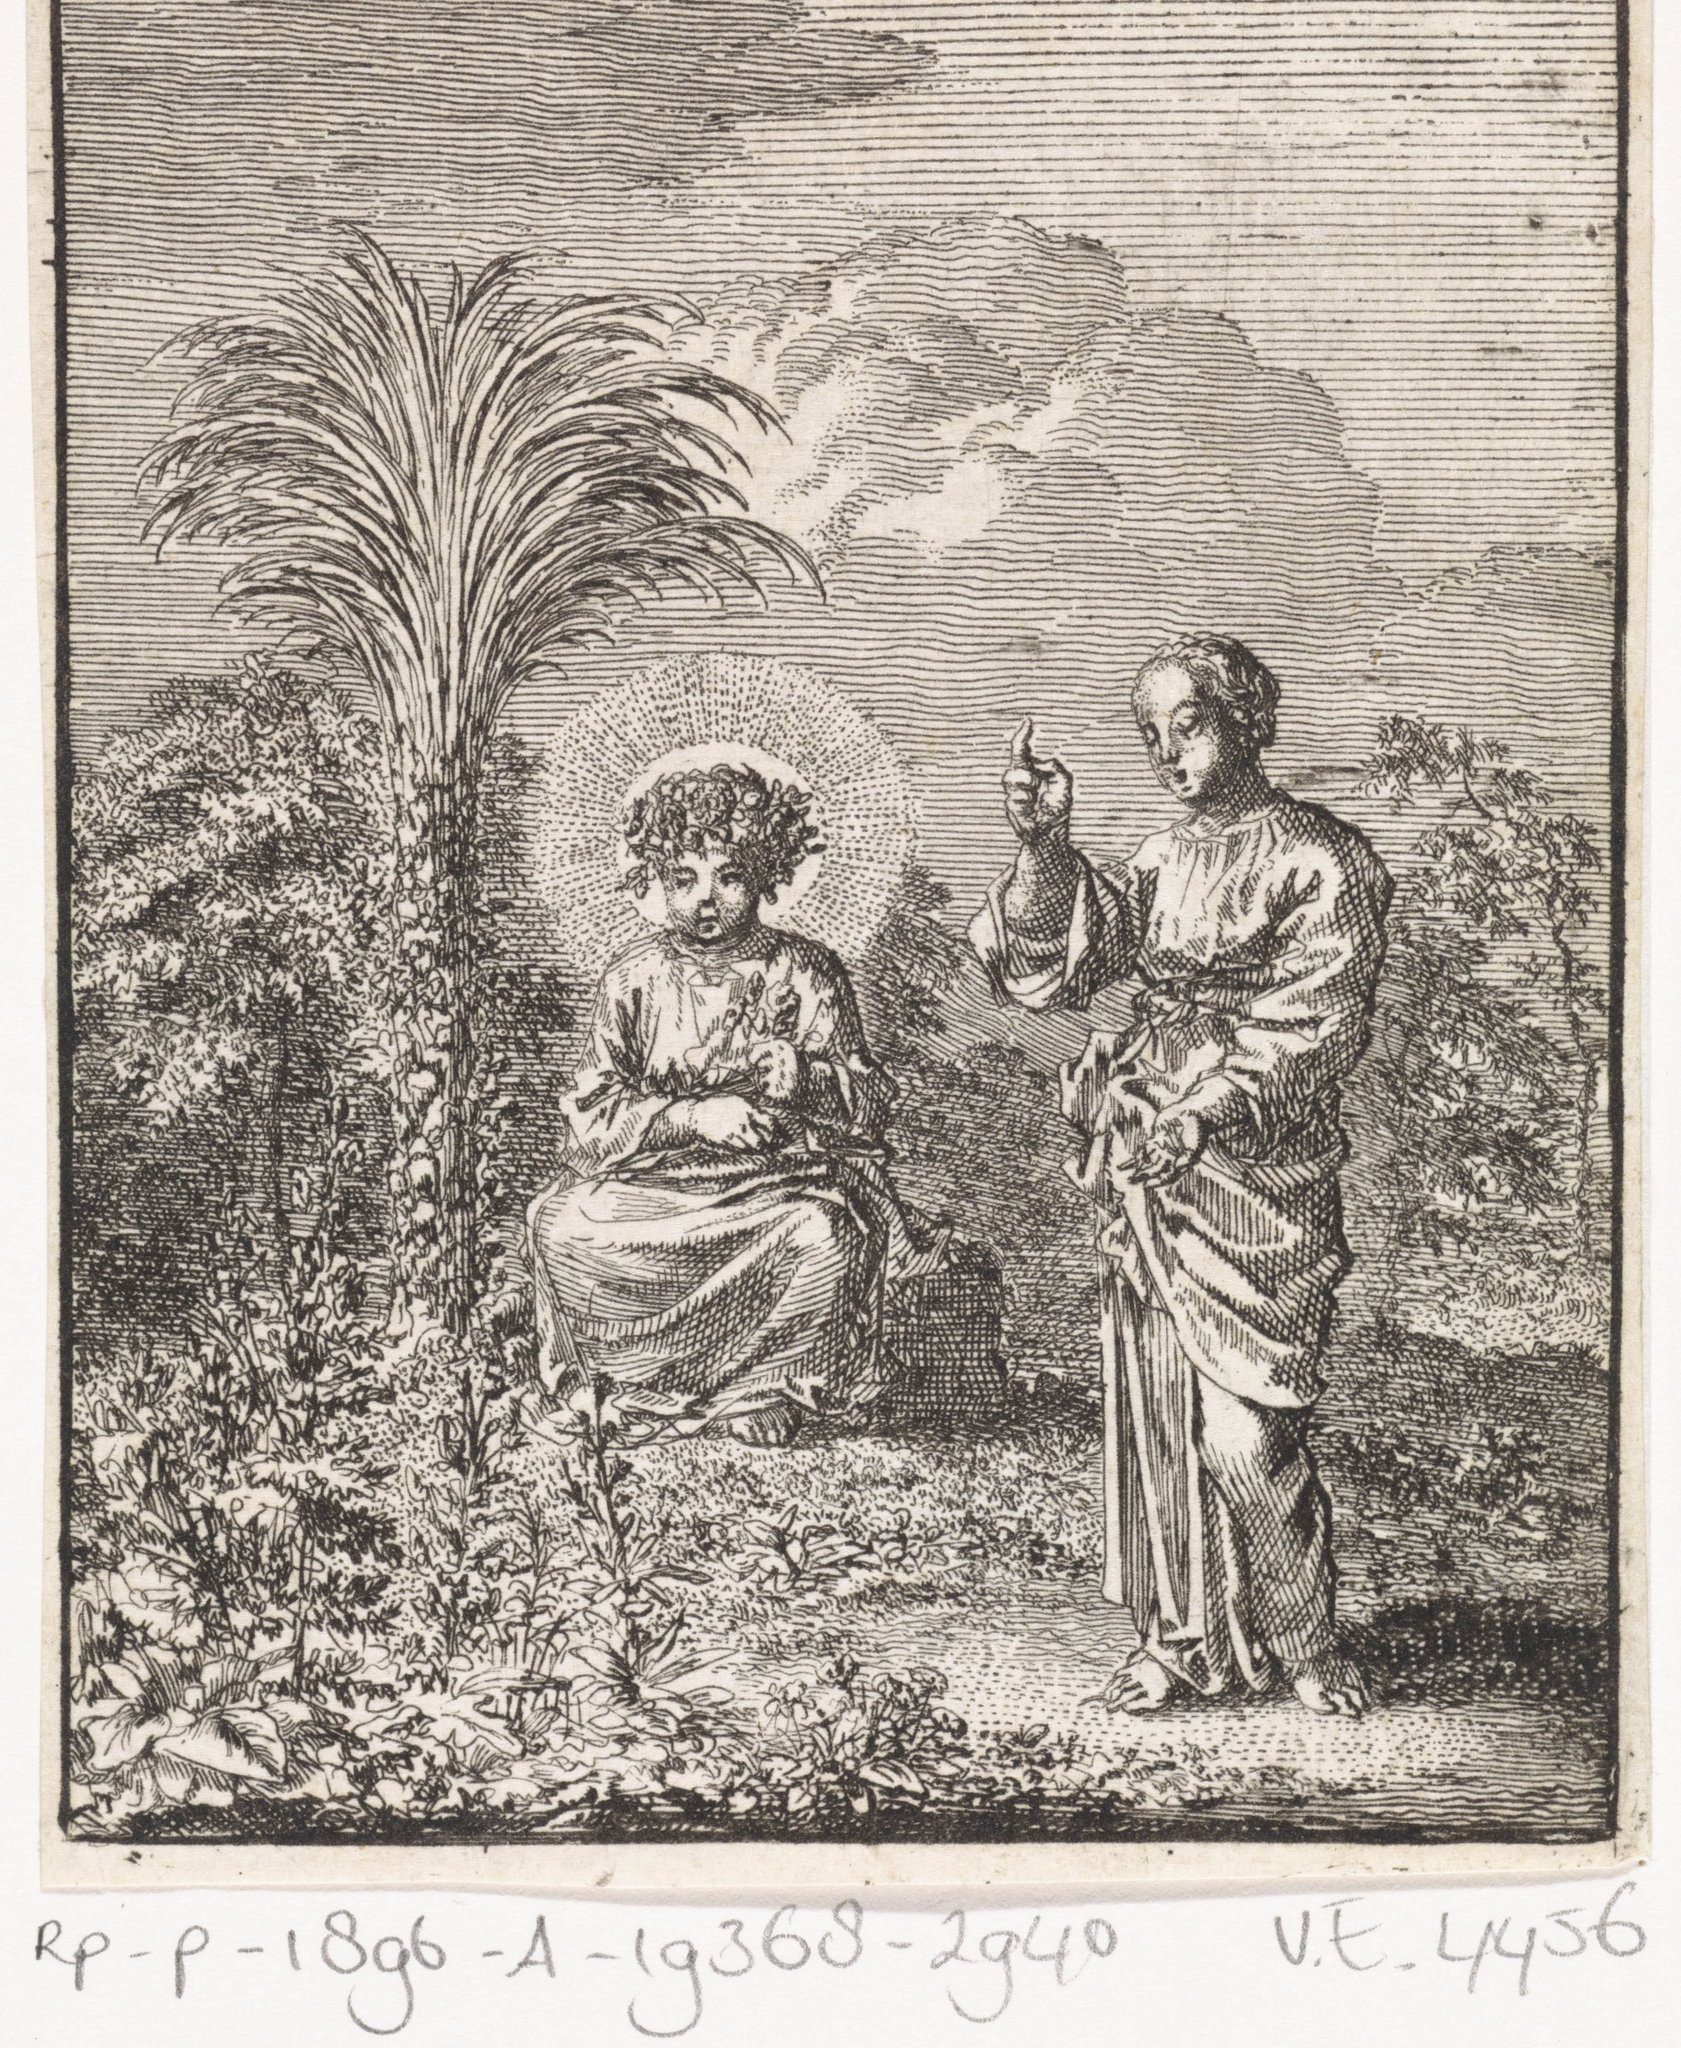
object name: print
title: Christus en de gepersonifieerde ziel aanschouwen de natuur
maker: jan luyken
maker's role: draughtsman, print maker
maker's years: 1649-1712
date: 1714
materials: paper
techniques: etching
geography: amsterdam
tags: plants; vegetation, christ and the soul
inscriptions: collector's mark: Lugt 2228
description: Proefdruk van illustratie uit: Luyken, Jan. Jezus en de Ziel, 3 delen. Amsterdam: Wed. Pieter Arentsz II en Cornelis van der Sys, 1714, dl. II, p. 73.